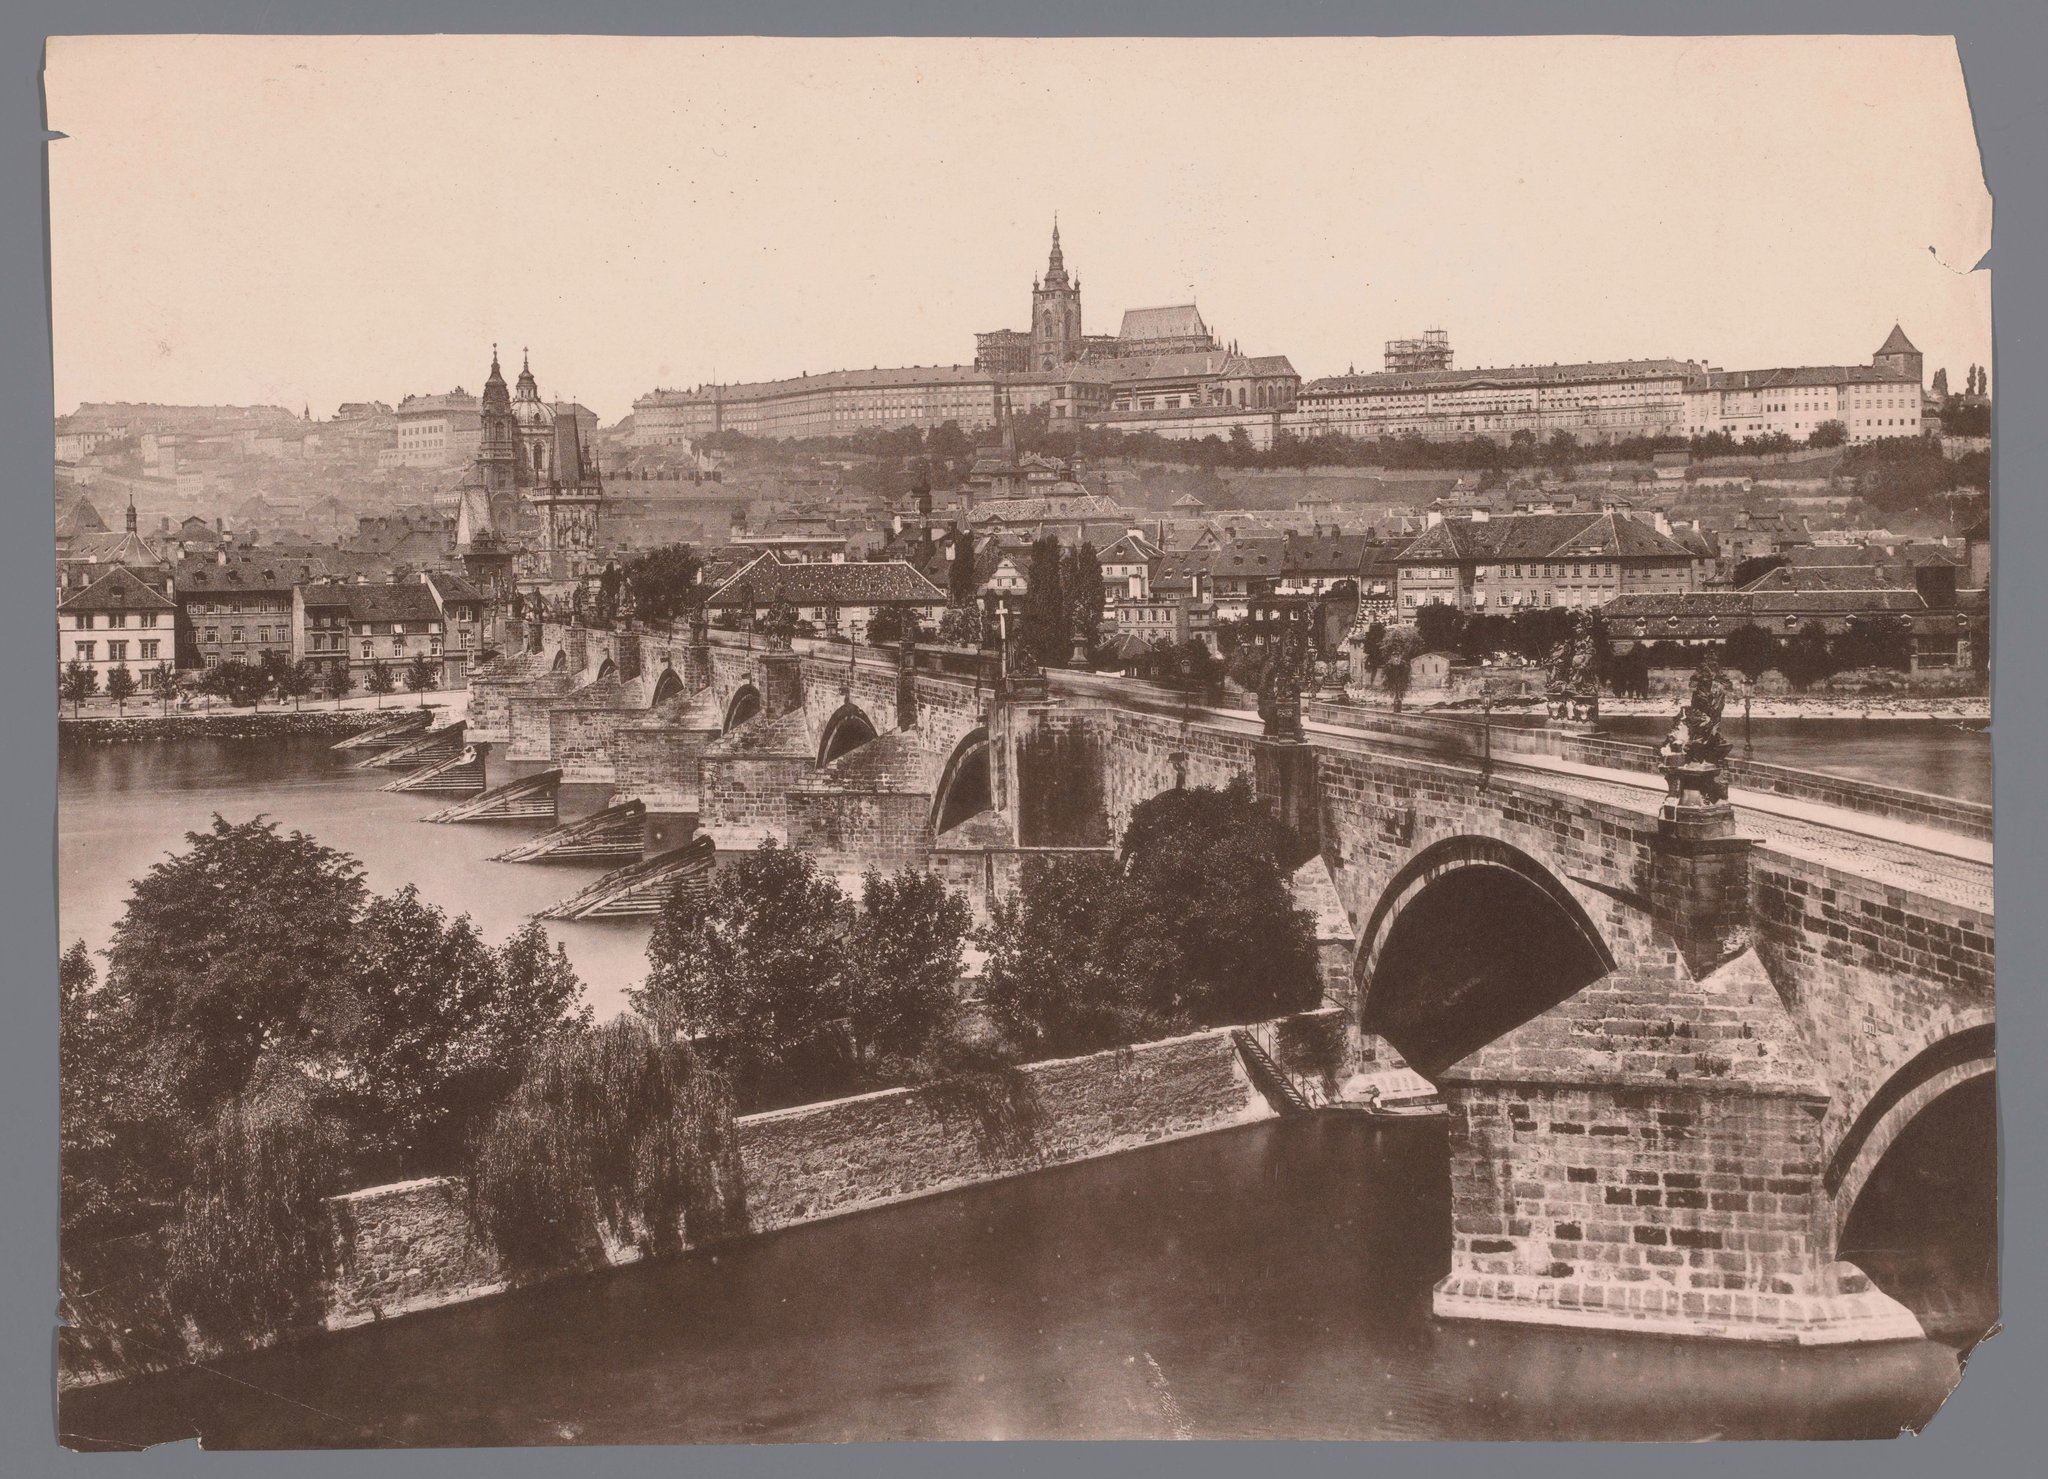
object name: photomechanical print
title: Gezicht op de Praagse burcht op het Hradčany en de Karelsbrug over de Moldau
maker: Anonymous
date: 1870-1930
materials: paper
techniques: photograph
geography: prague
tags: palace, bridge in city across river, canal, etc.